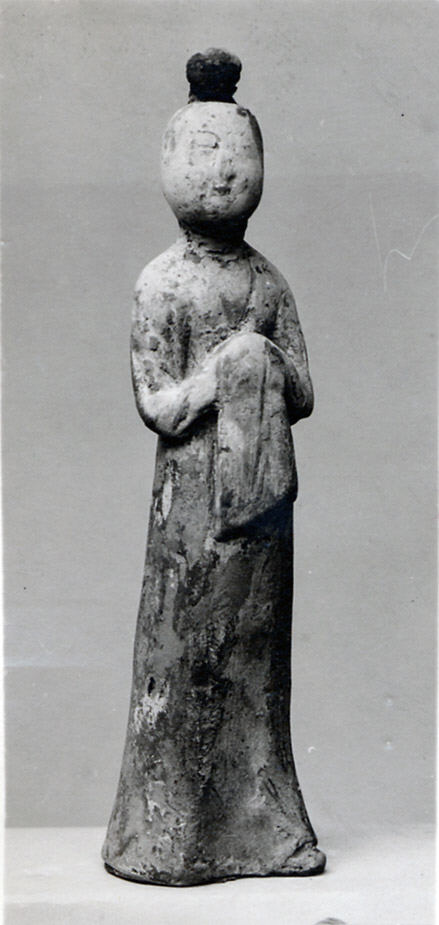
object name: figure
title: Female attendant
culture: chinese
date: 601-800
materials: earthenware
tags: women